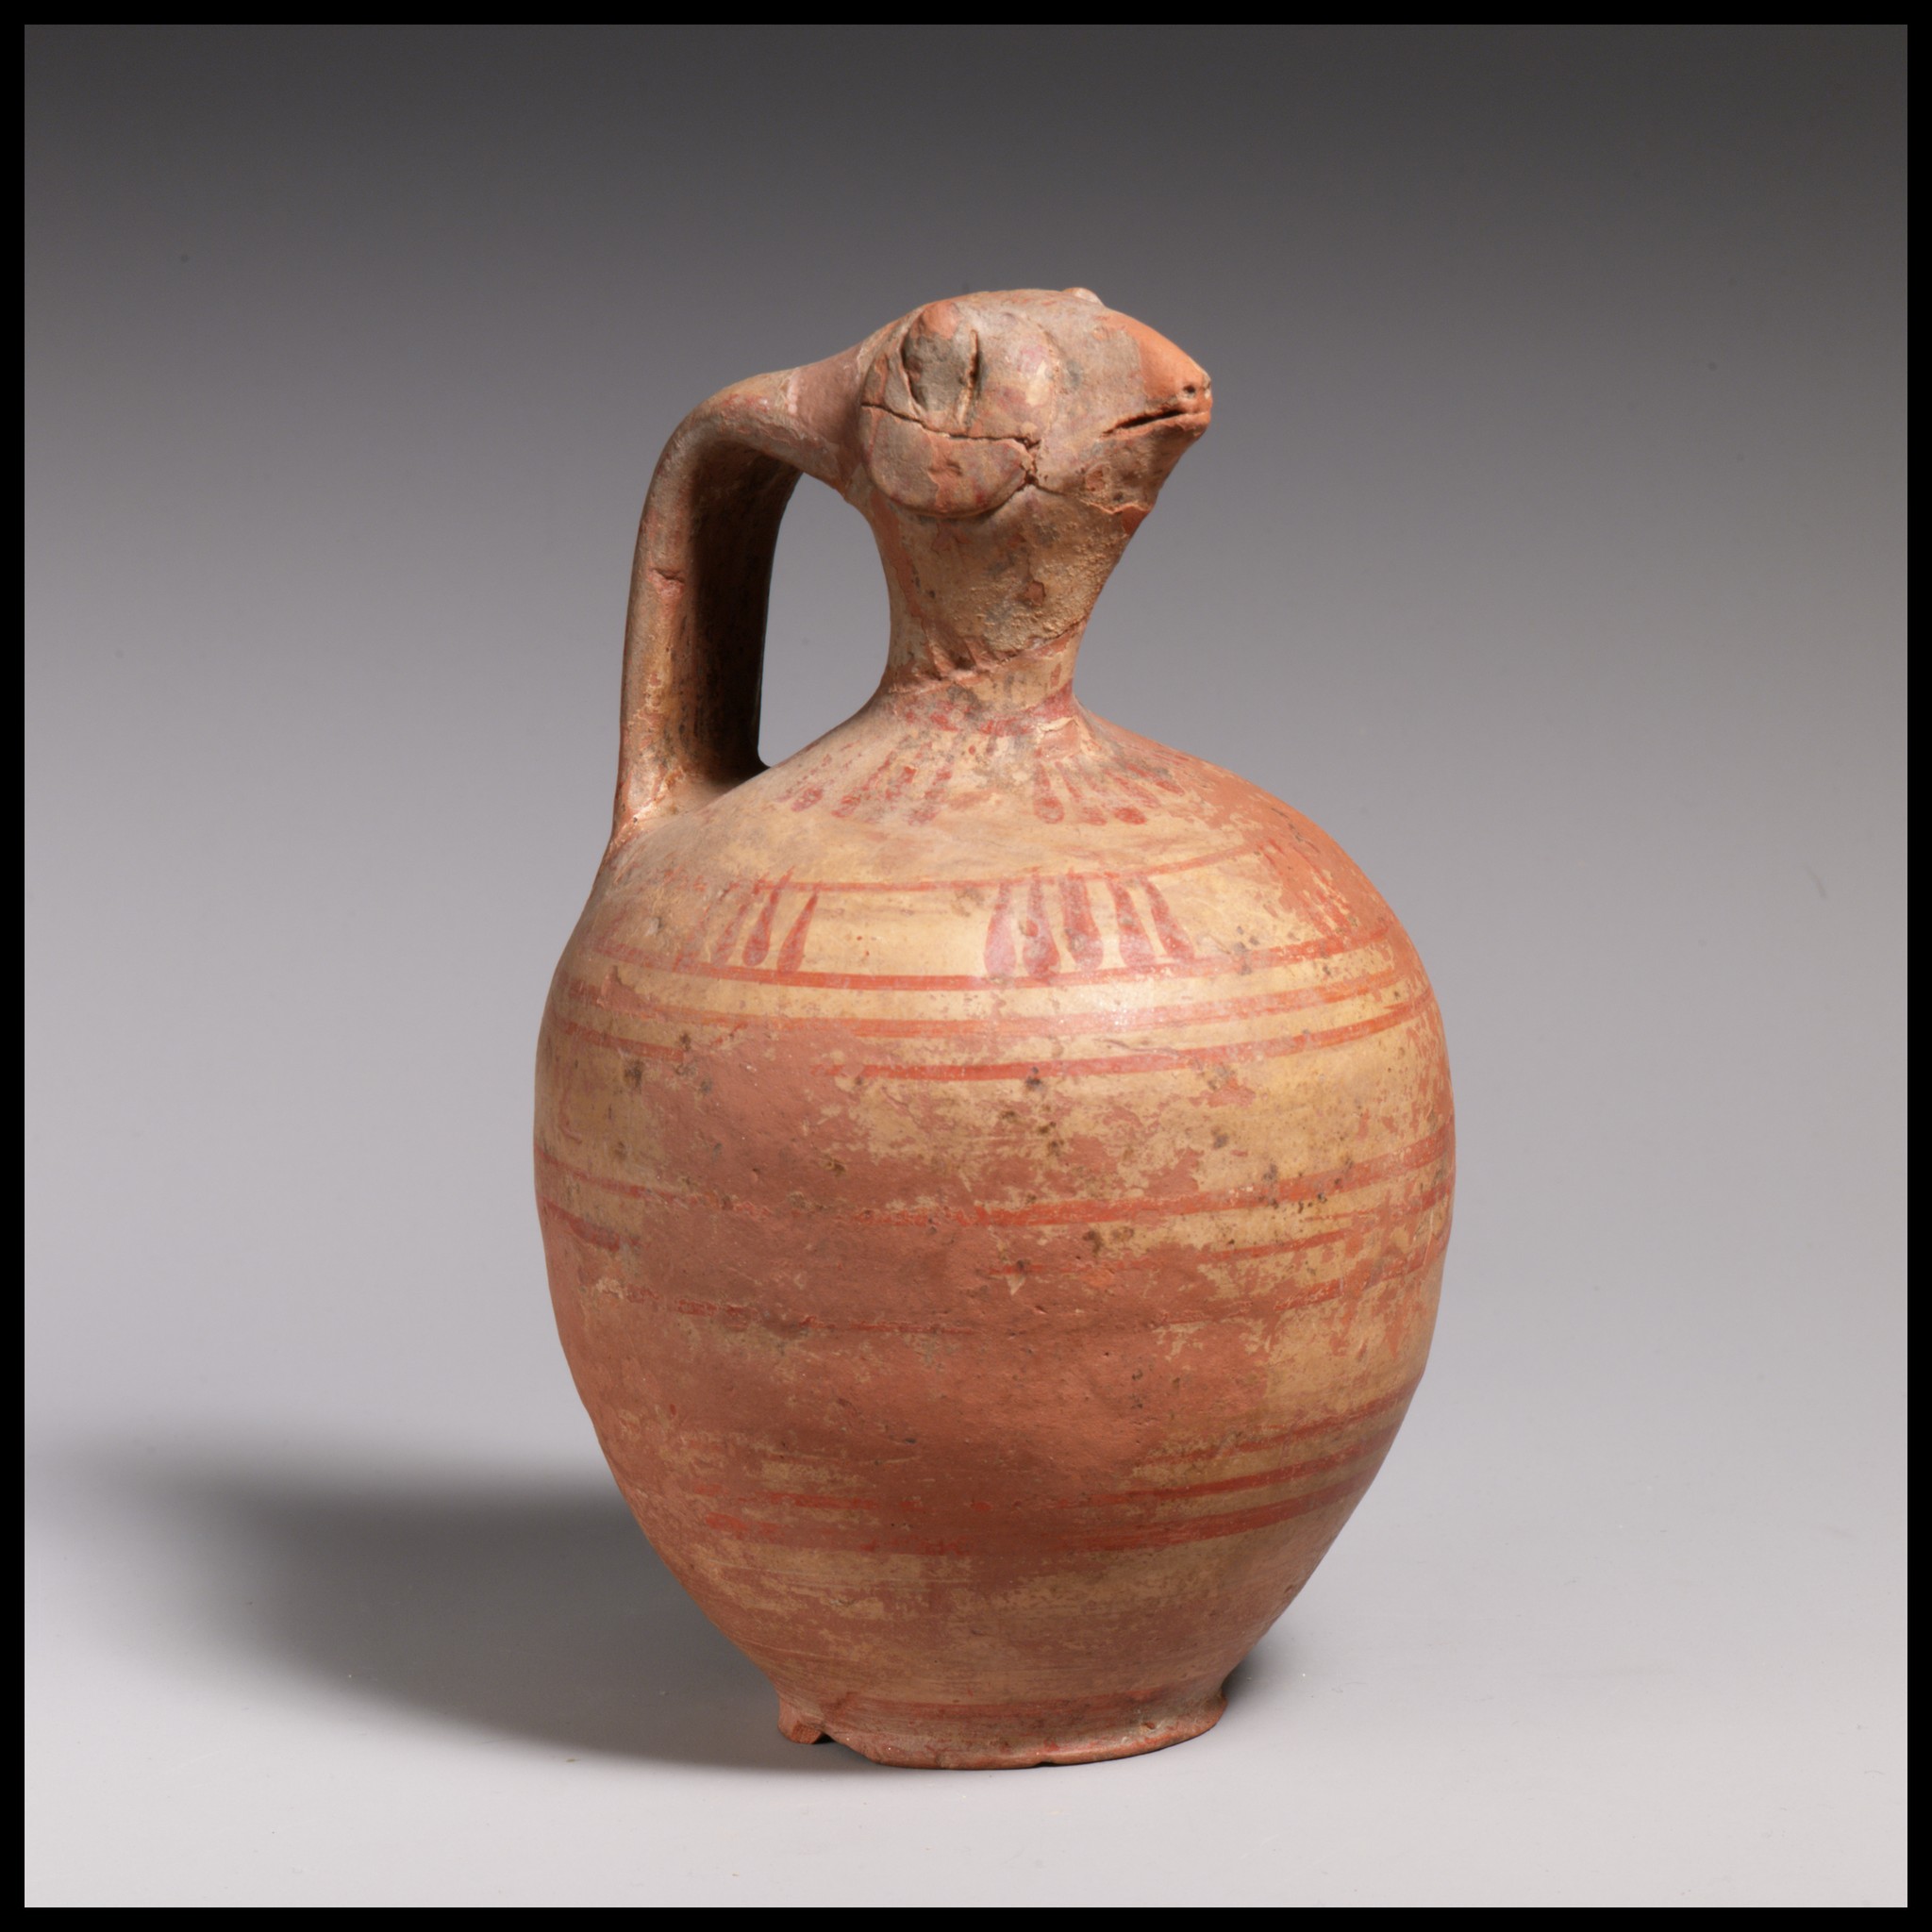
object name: jug, siphon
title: Terracotta siphon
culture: lydian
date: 600-501 BCE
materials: terracotta